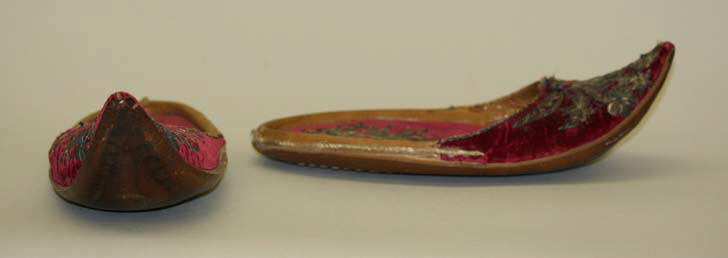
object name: slipper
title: Slippers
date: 1867-1900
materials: leather, metal thread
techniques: embroidery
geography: turkey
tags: footwear